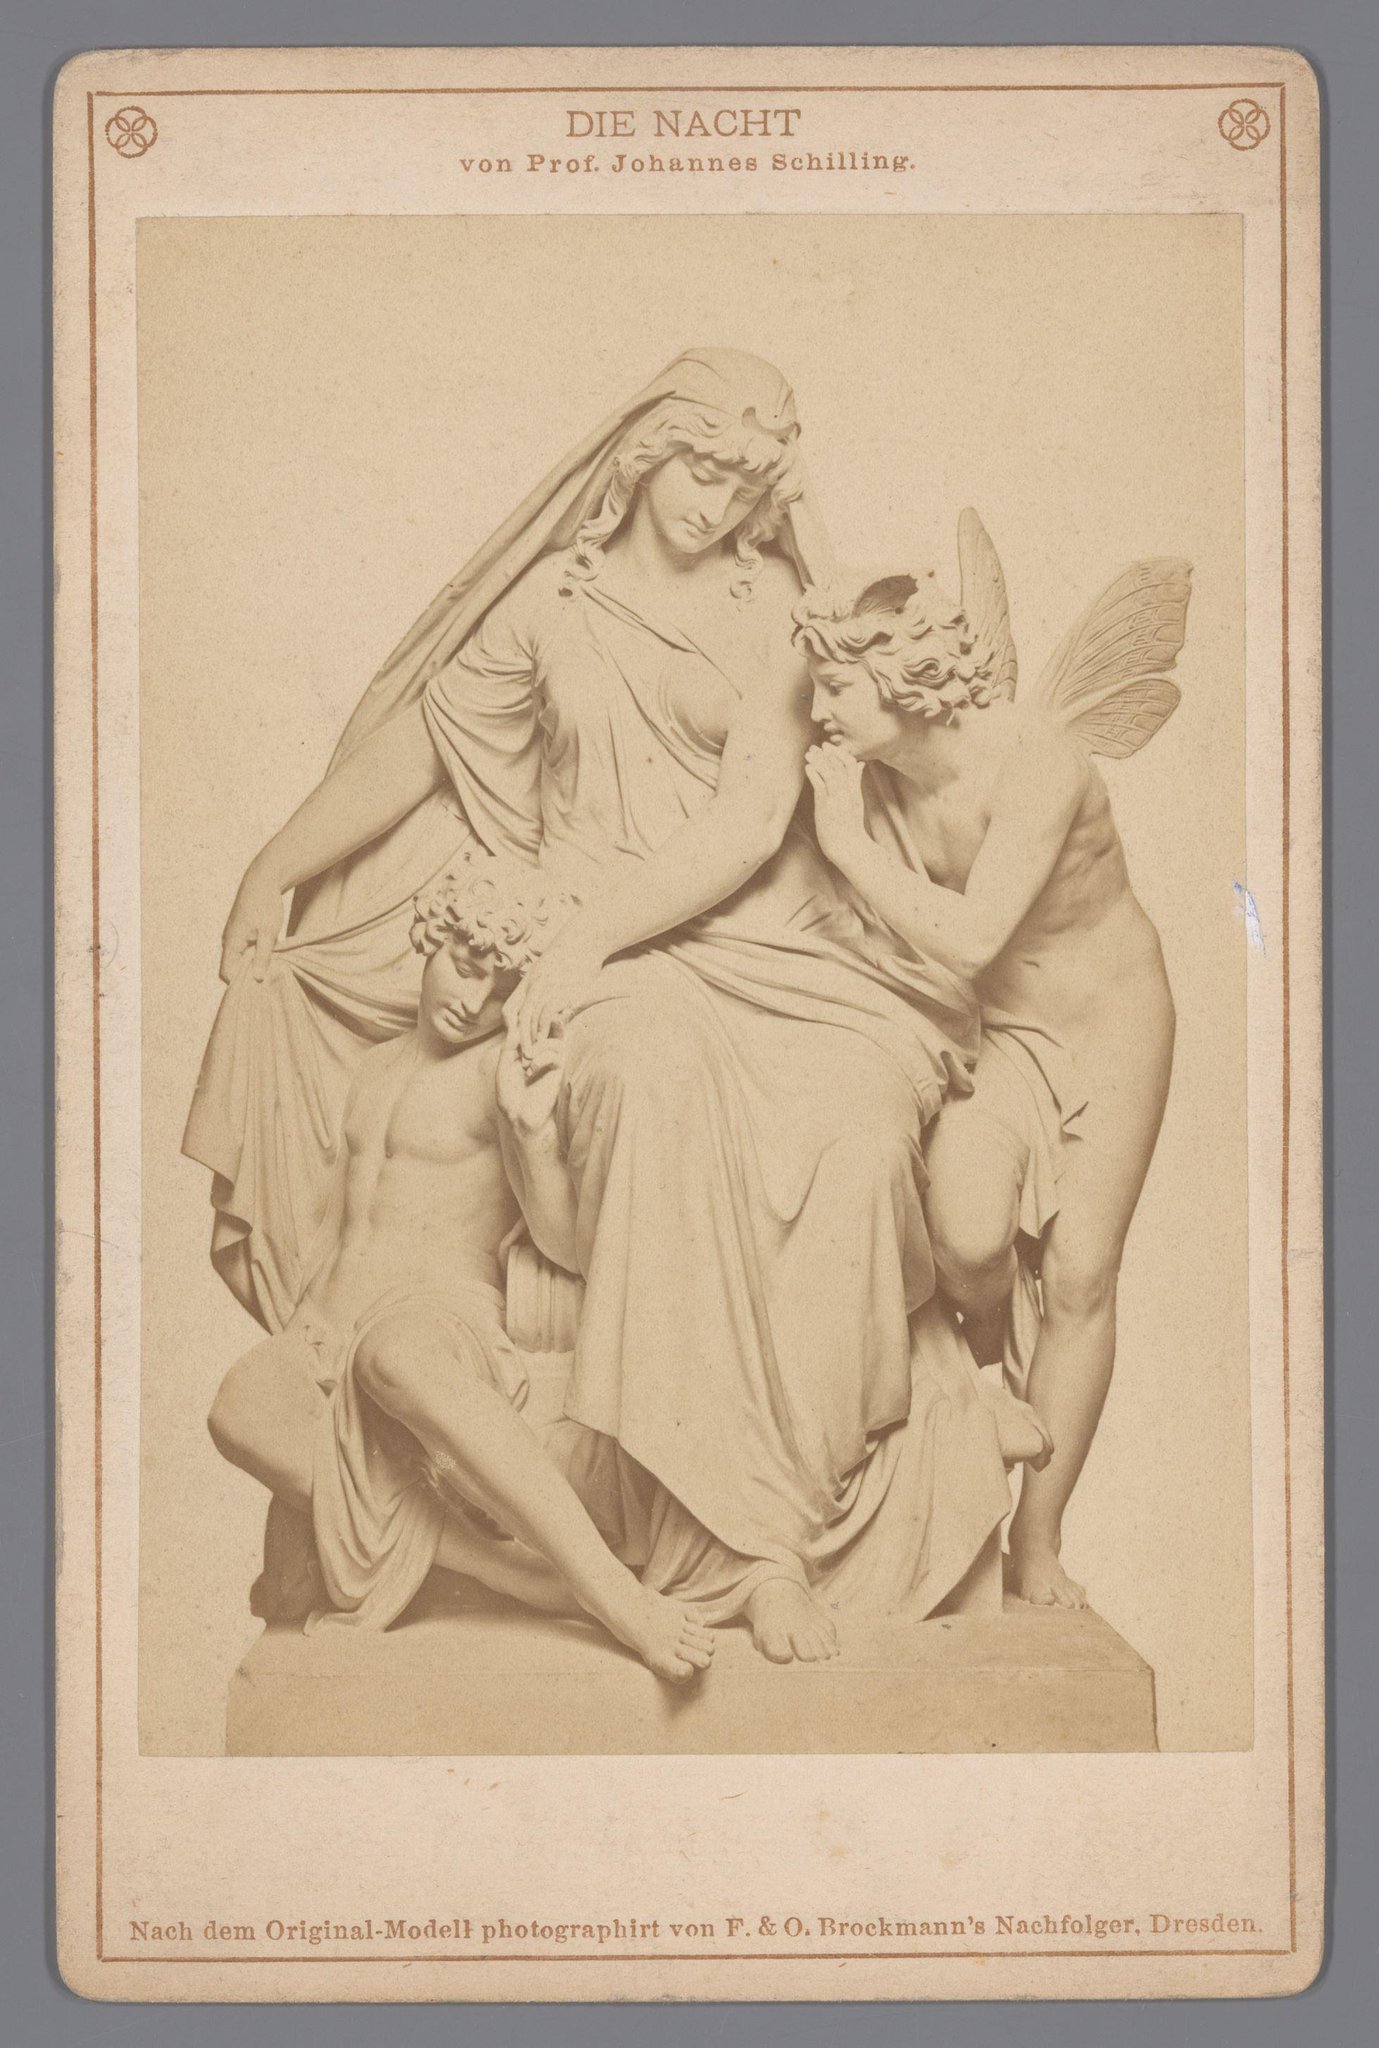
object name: photograph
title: Die Nacht van Johannes Schilling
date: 1850-1900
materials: cardboard, photographic support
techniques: albumen print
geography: dresden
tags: classical mythology and ancient history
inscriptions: inscription: ‘Nach dem Original-Modell photographirt von F. & O. Brockmann's Nachfolger, Dresden.’, inscription: ‘von Prof. Johannes Schilling’